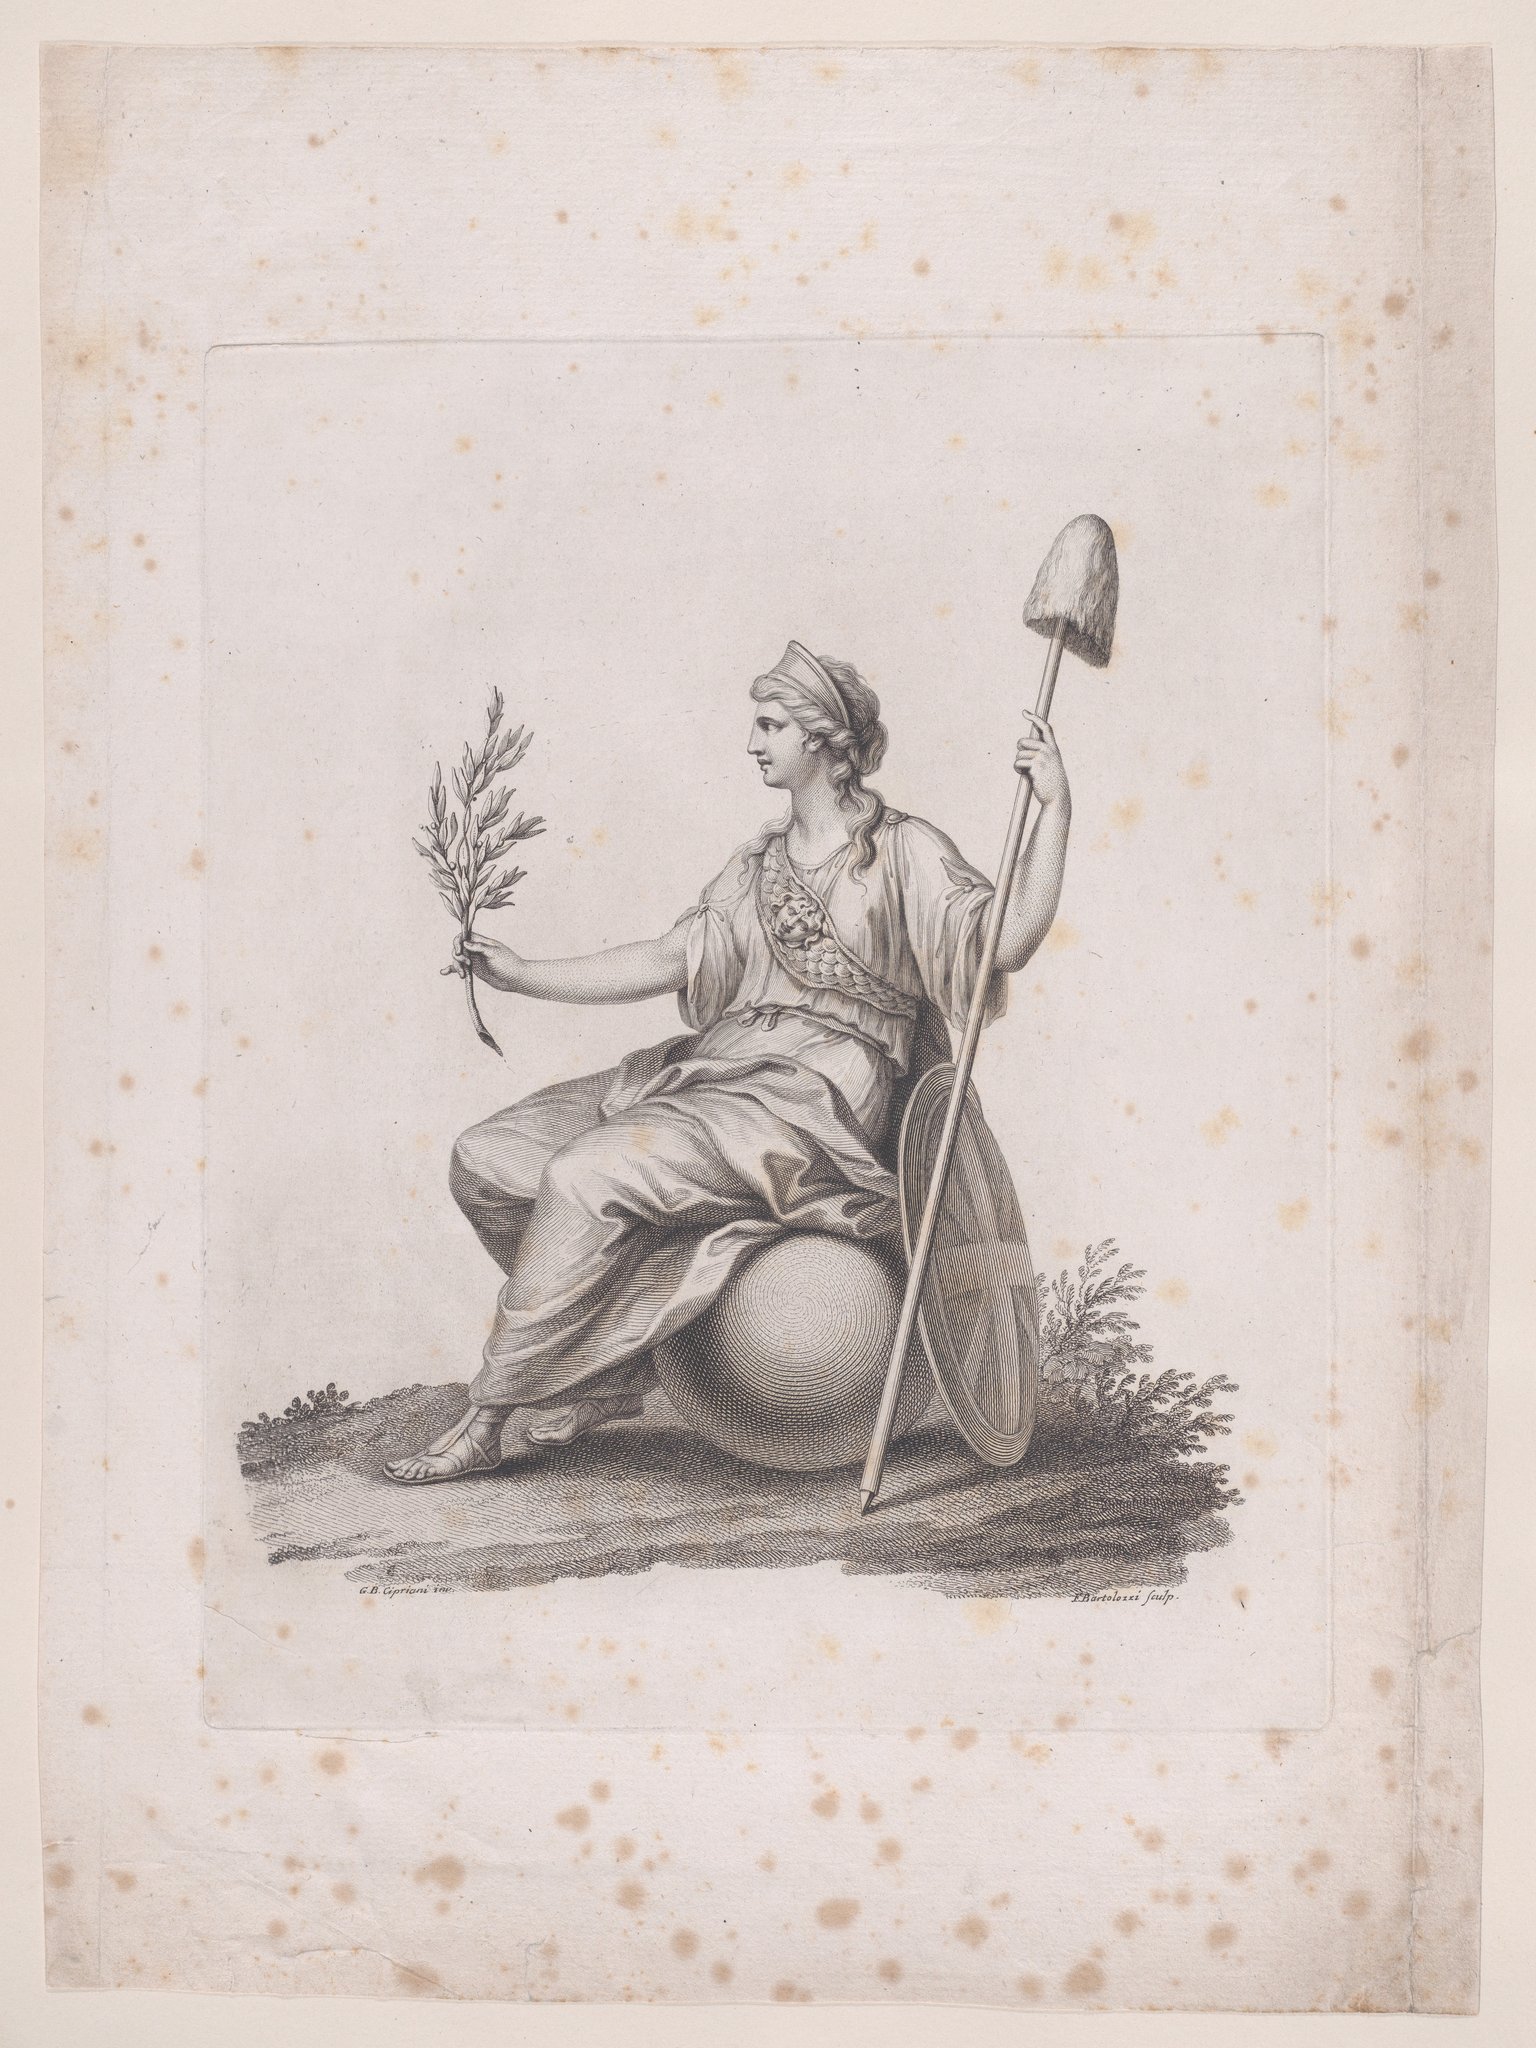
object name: print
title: Britannia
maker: francesco bartolozzi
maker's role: artist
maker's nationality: italian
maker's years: 1728-1815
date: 1775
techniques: engraving, etching